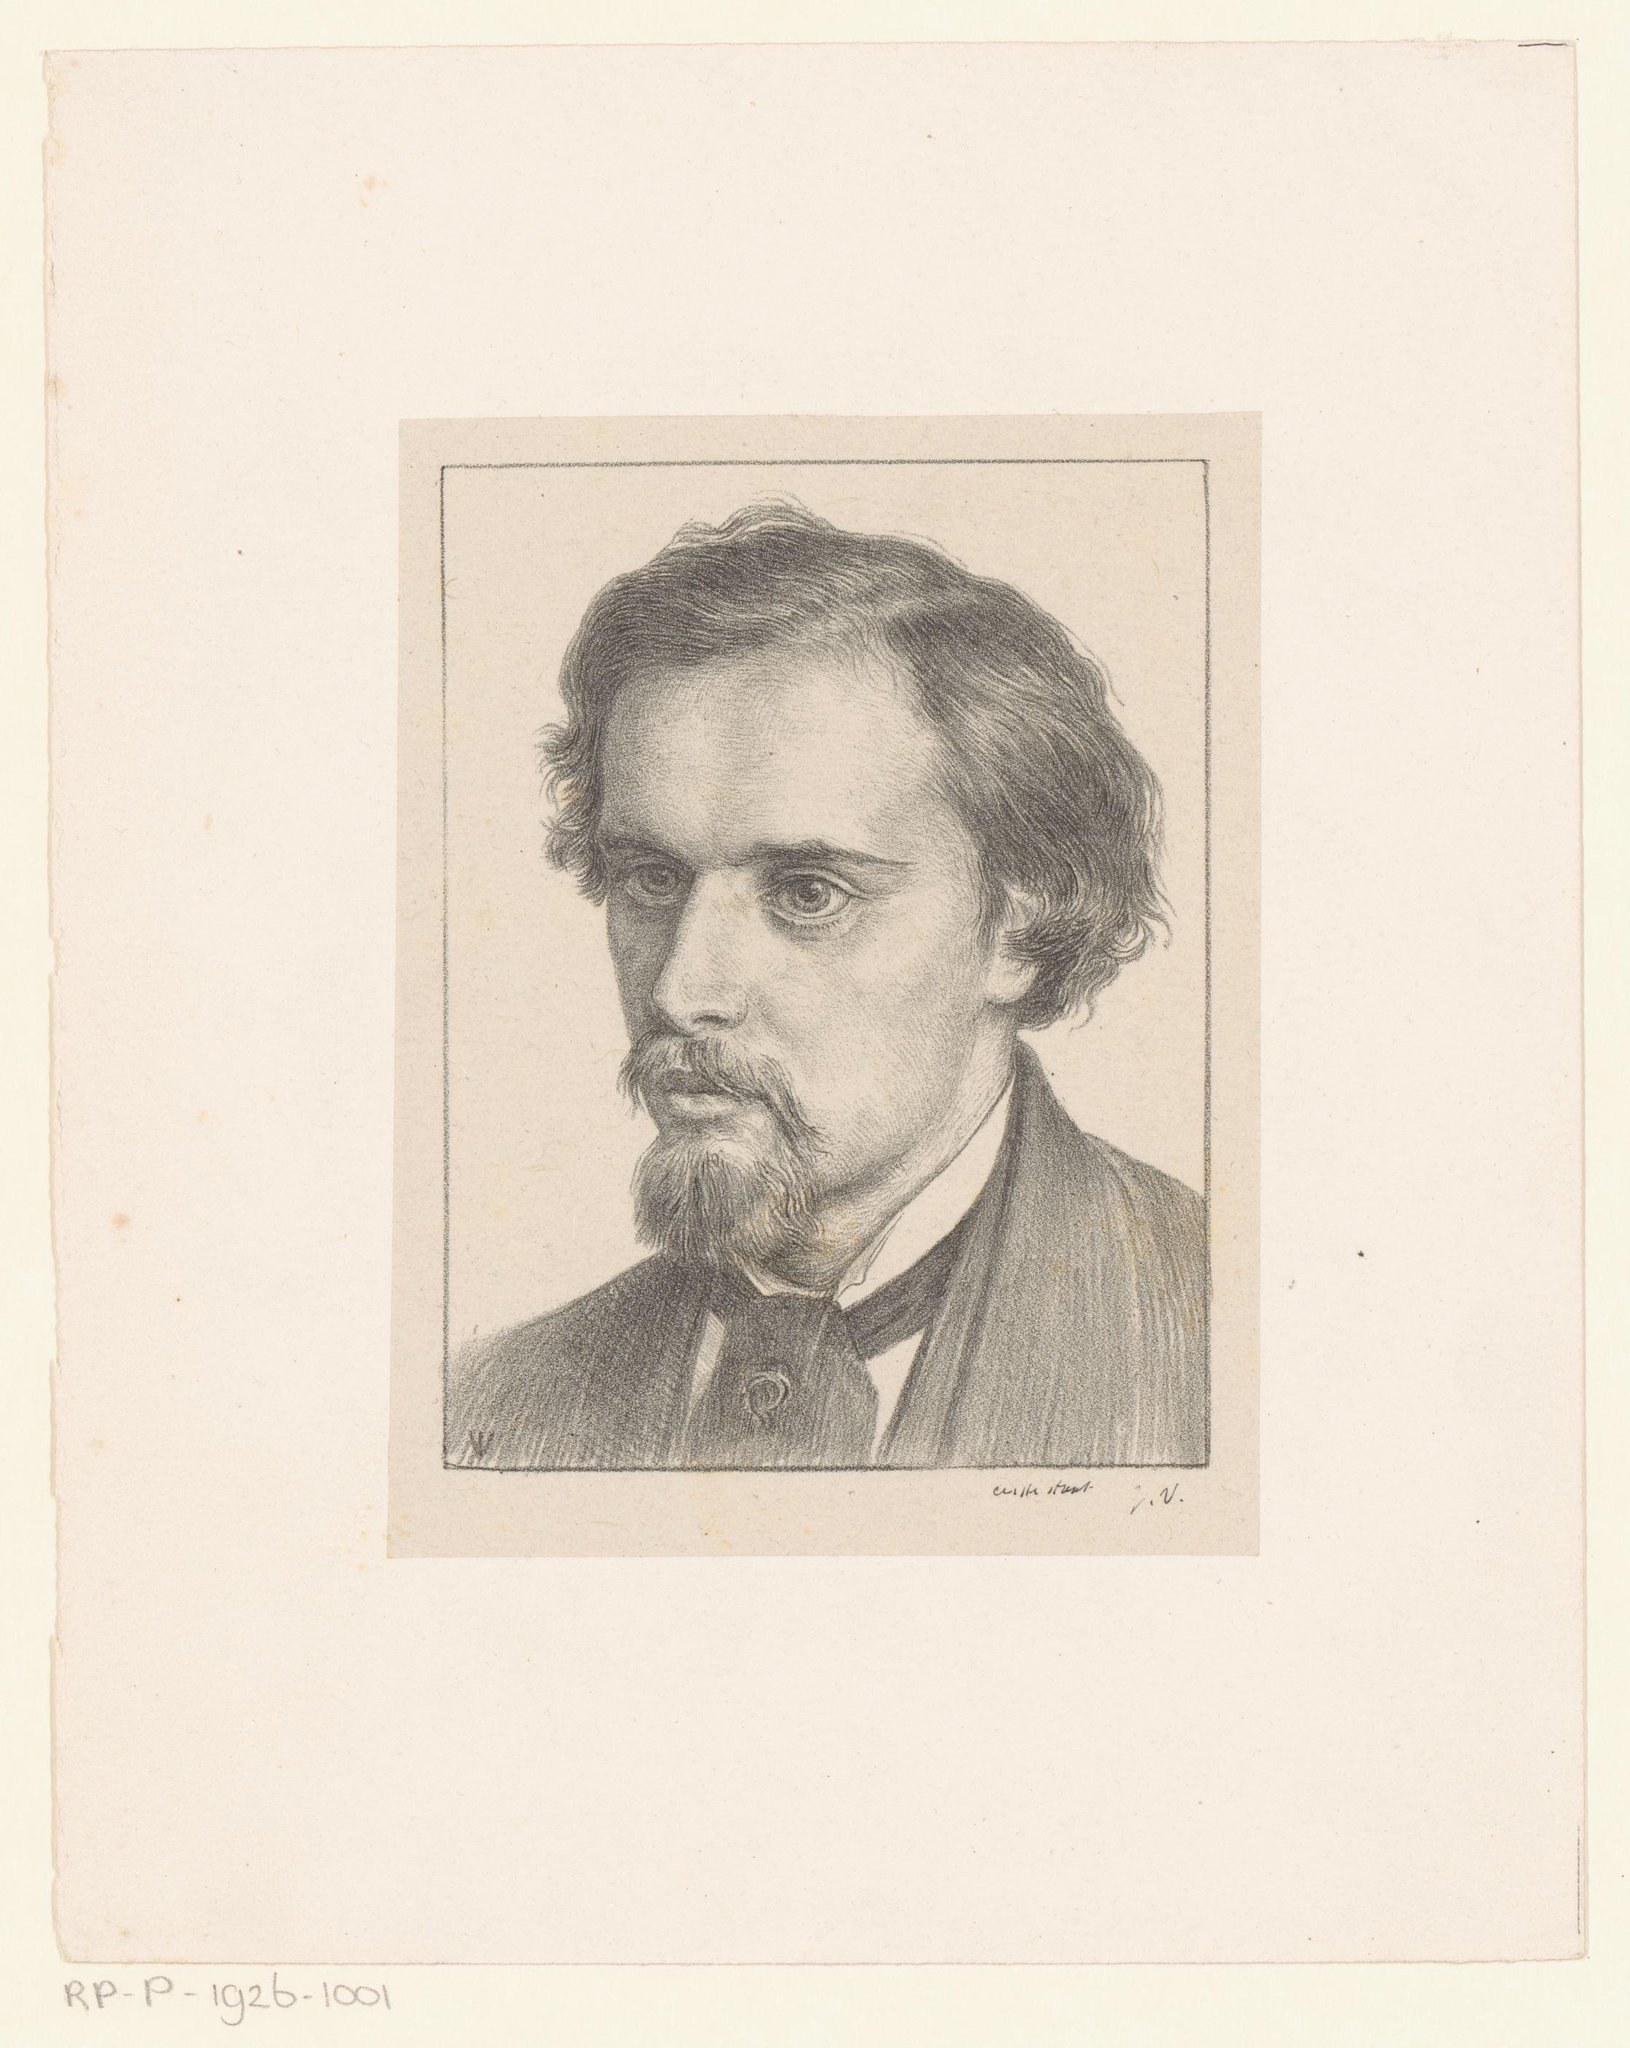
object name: print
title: Portret van Dante Gabriel Rossetti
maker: jan veth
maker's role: designer, draughtsman, painter, print maker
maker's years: 1864-1925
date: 1898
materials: paper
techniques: lithograph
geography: netherlands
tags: london, draughtsman, dante gabriel rossetti, historical persons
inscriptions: inscription: ‘eerste staat / J.V.’, collector's mark: ‘H.G. Samson Amsterdam’, collector's mark: Lugt 2228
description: Prent uit: Mannen en vrouwen van Beteekenis, Haarlem 1898. Zie Bijl de Vroe 1987.